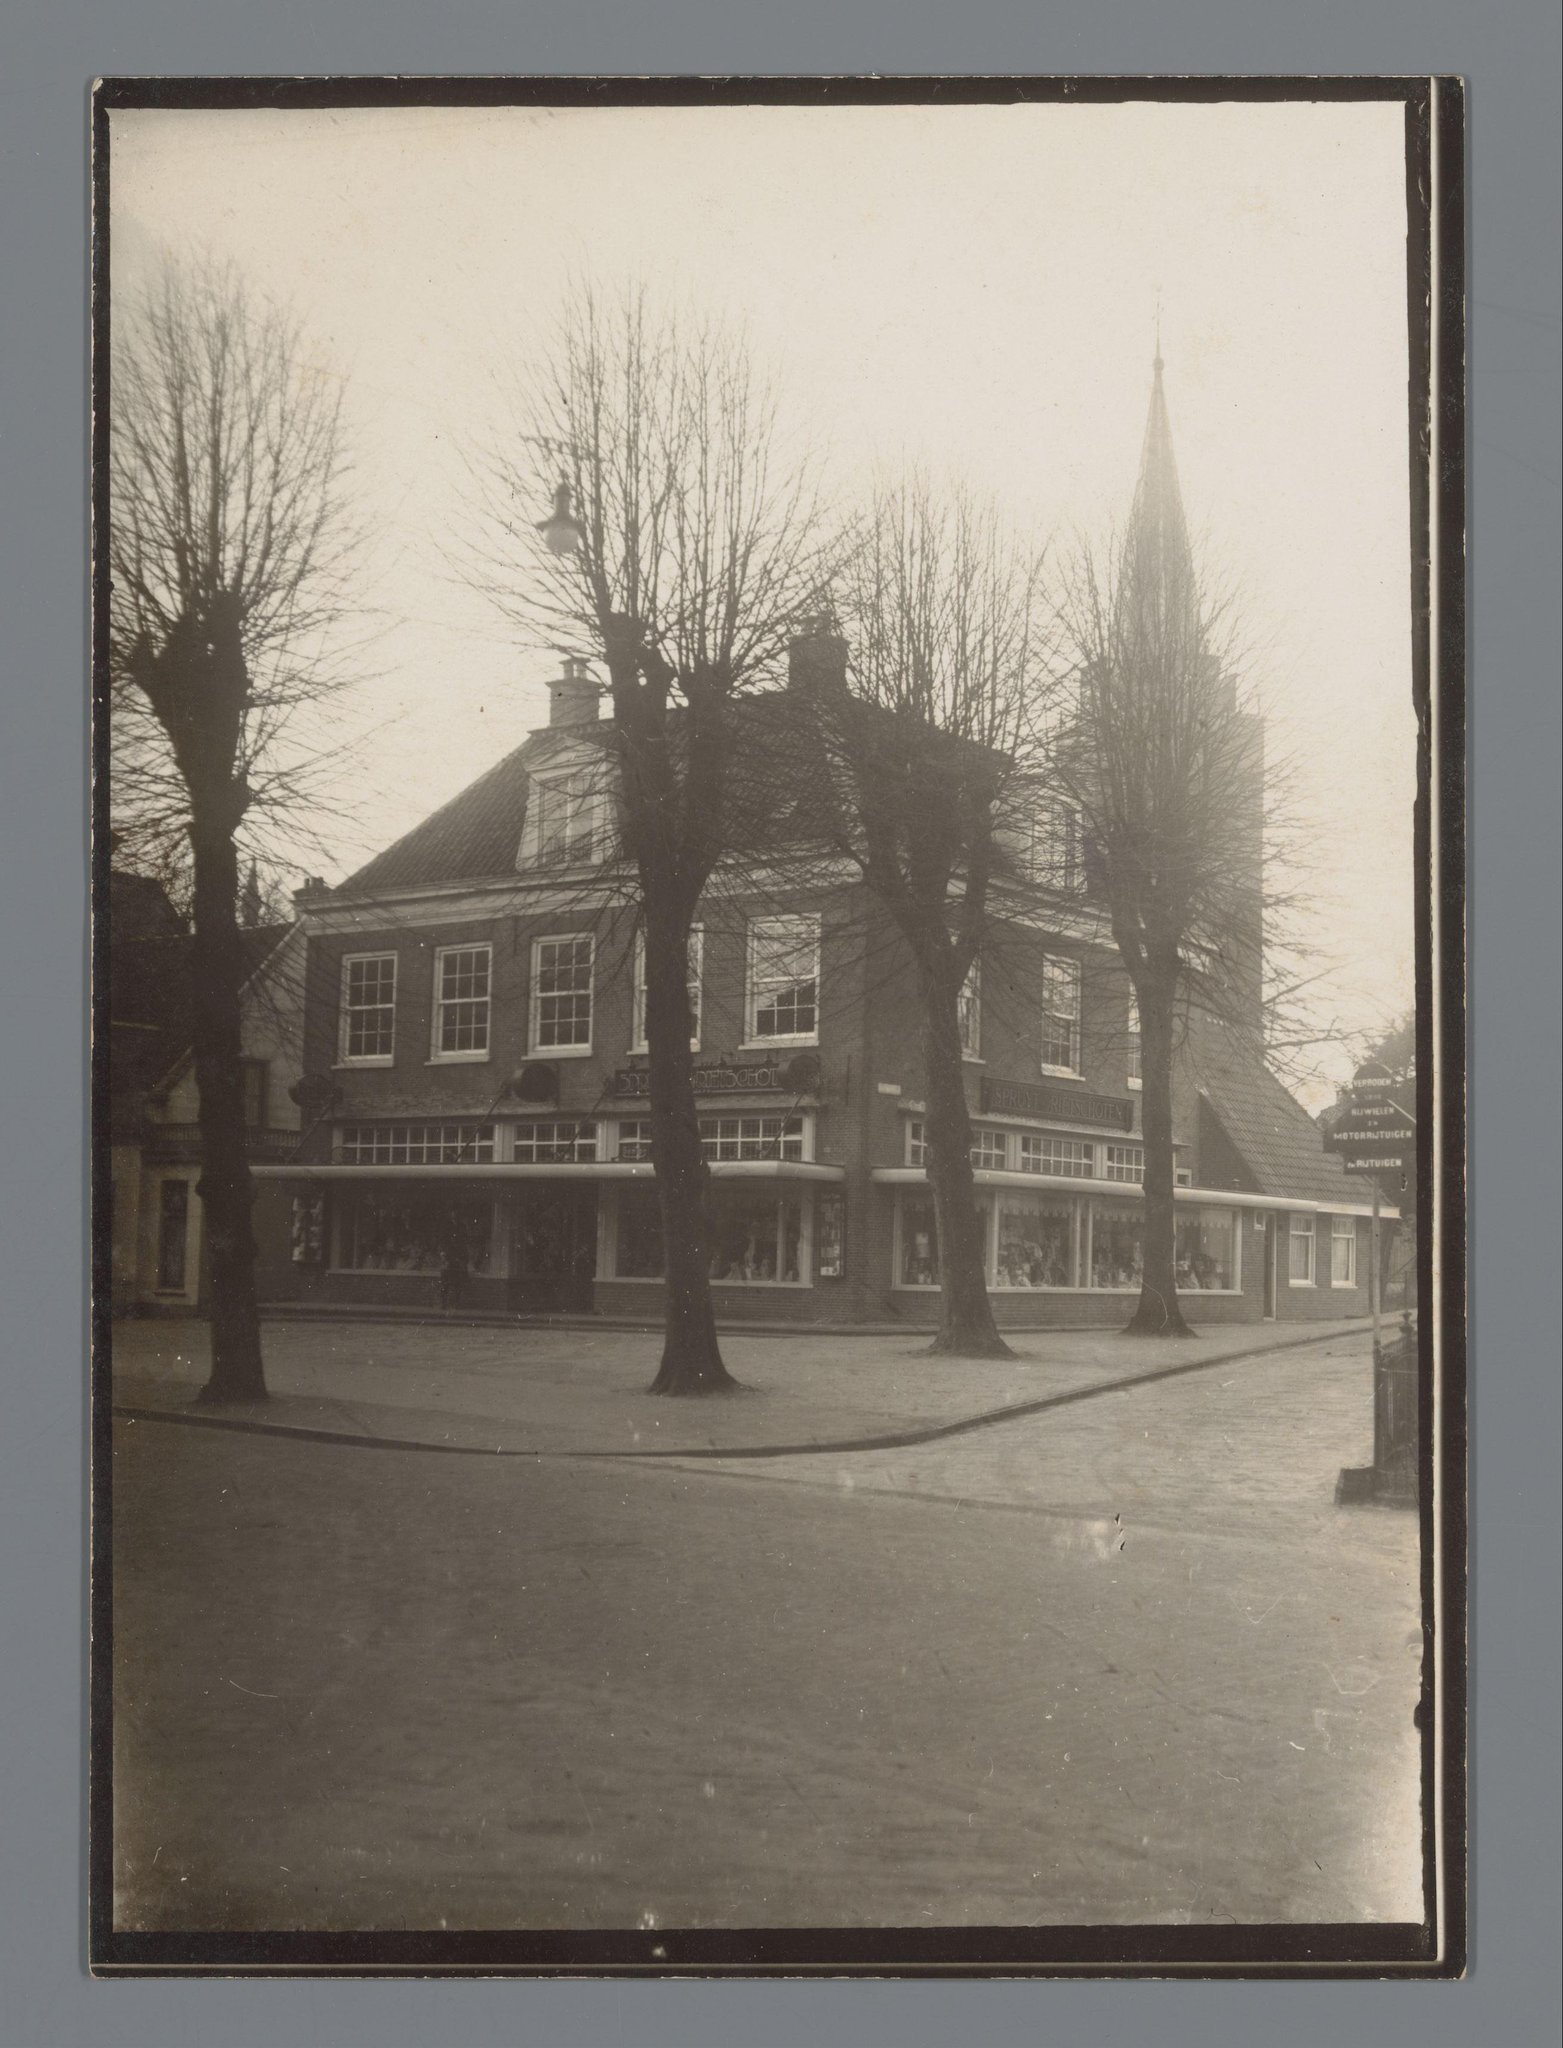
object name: photograph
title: Gezicht op winkel Spruyt van Rietschoten te Hilversum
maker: Anonymous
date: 1900-1930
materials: photographic support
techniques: gelatin silver print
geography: hilversum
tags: shop, store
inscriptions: inscription: ‘Vosmaer’, annotation: ‘Hilversum’